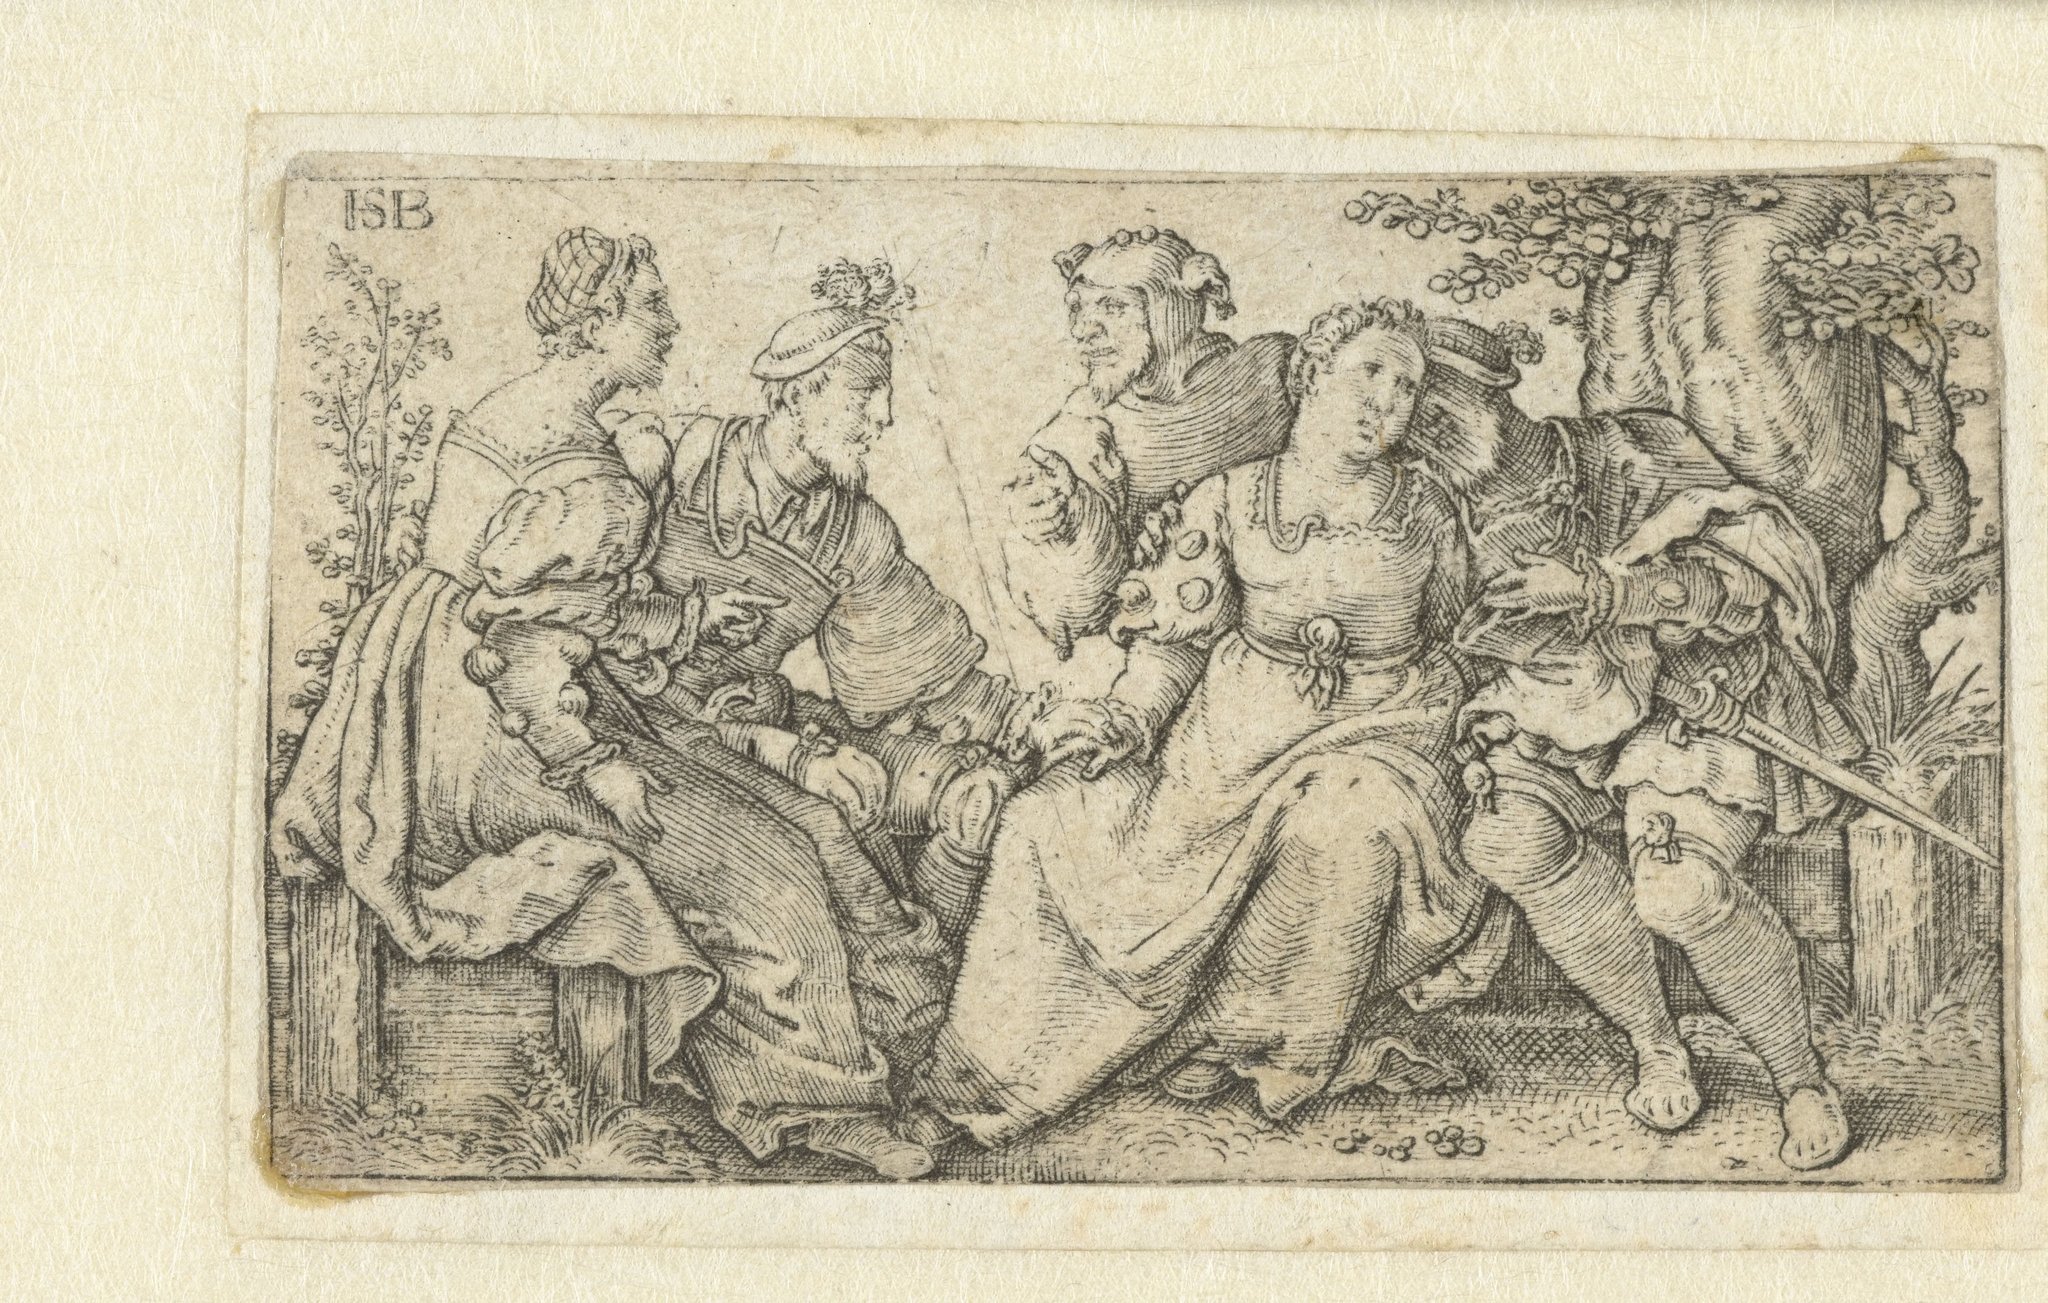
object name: print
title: Twee liefdesparen en een nar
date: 1535-1599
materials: paper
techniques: engraving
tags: buffoon (in general) (german: 'schalksnarr'), lovers; courting, flirting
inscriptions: collector's mark: Lugt 2228a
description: Kopie in spiegelbeeld naar een prent van Hans Sebald Beham welke de originele prent nauwkeurig volgt